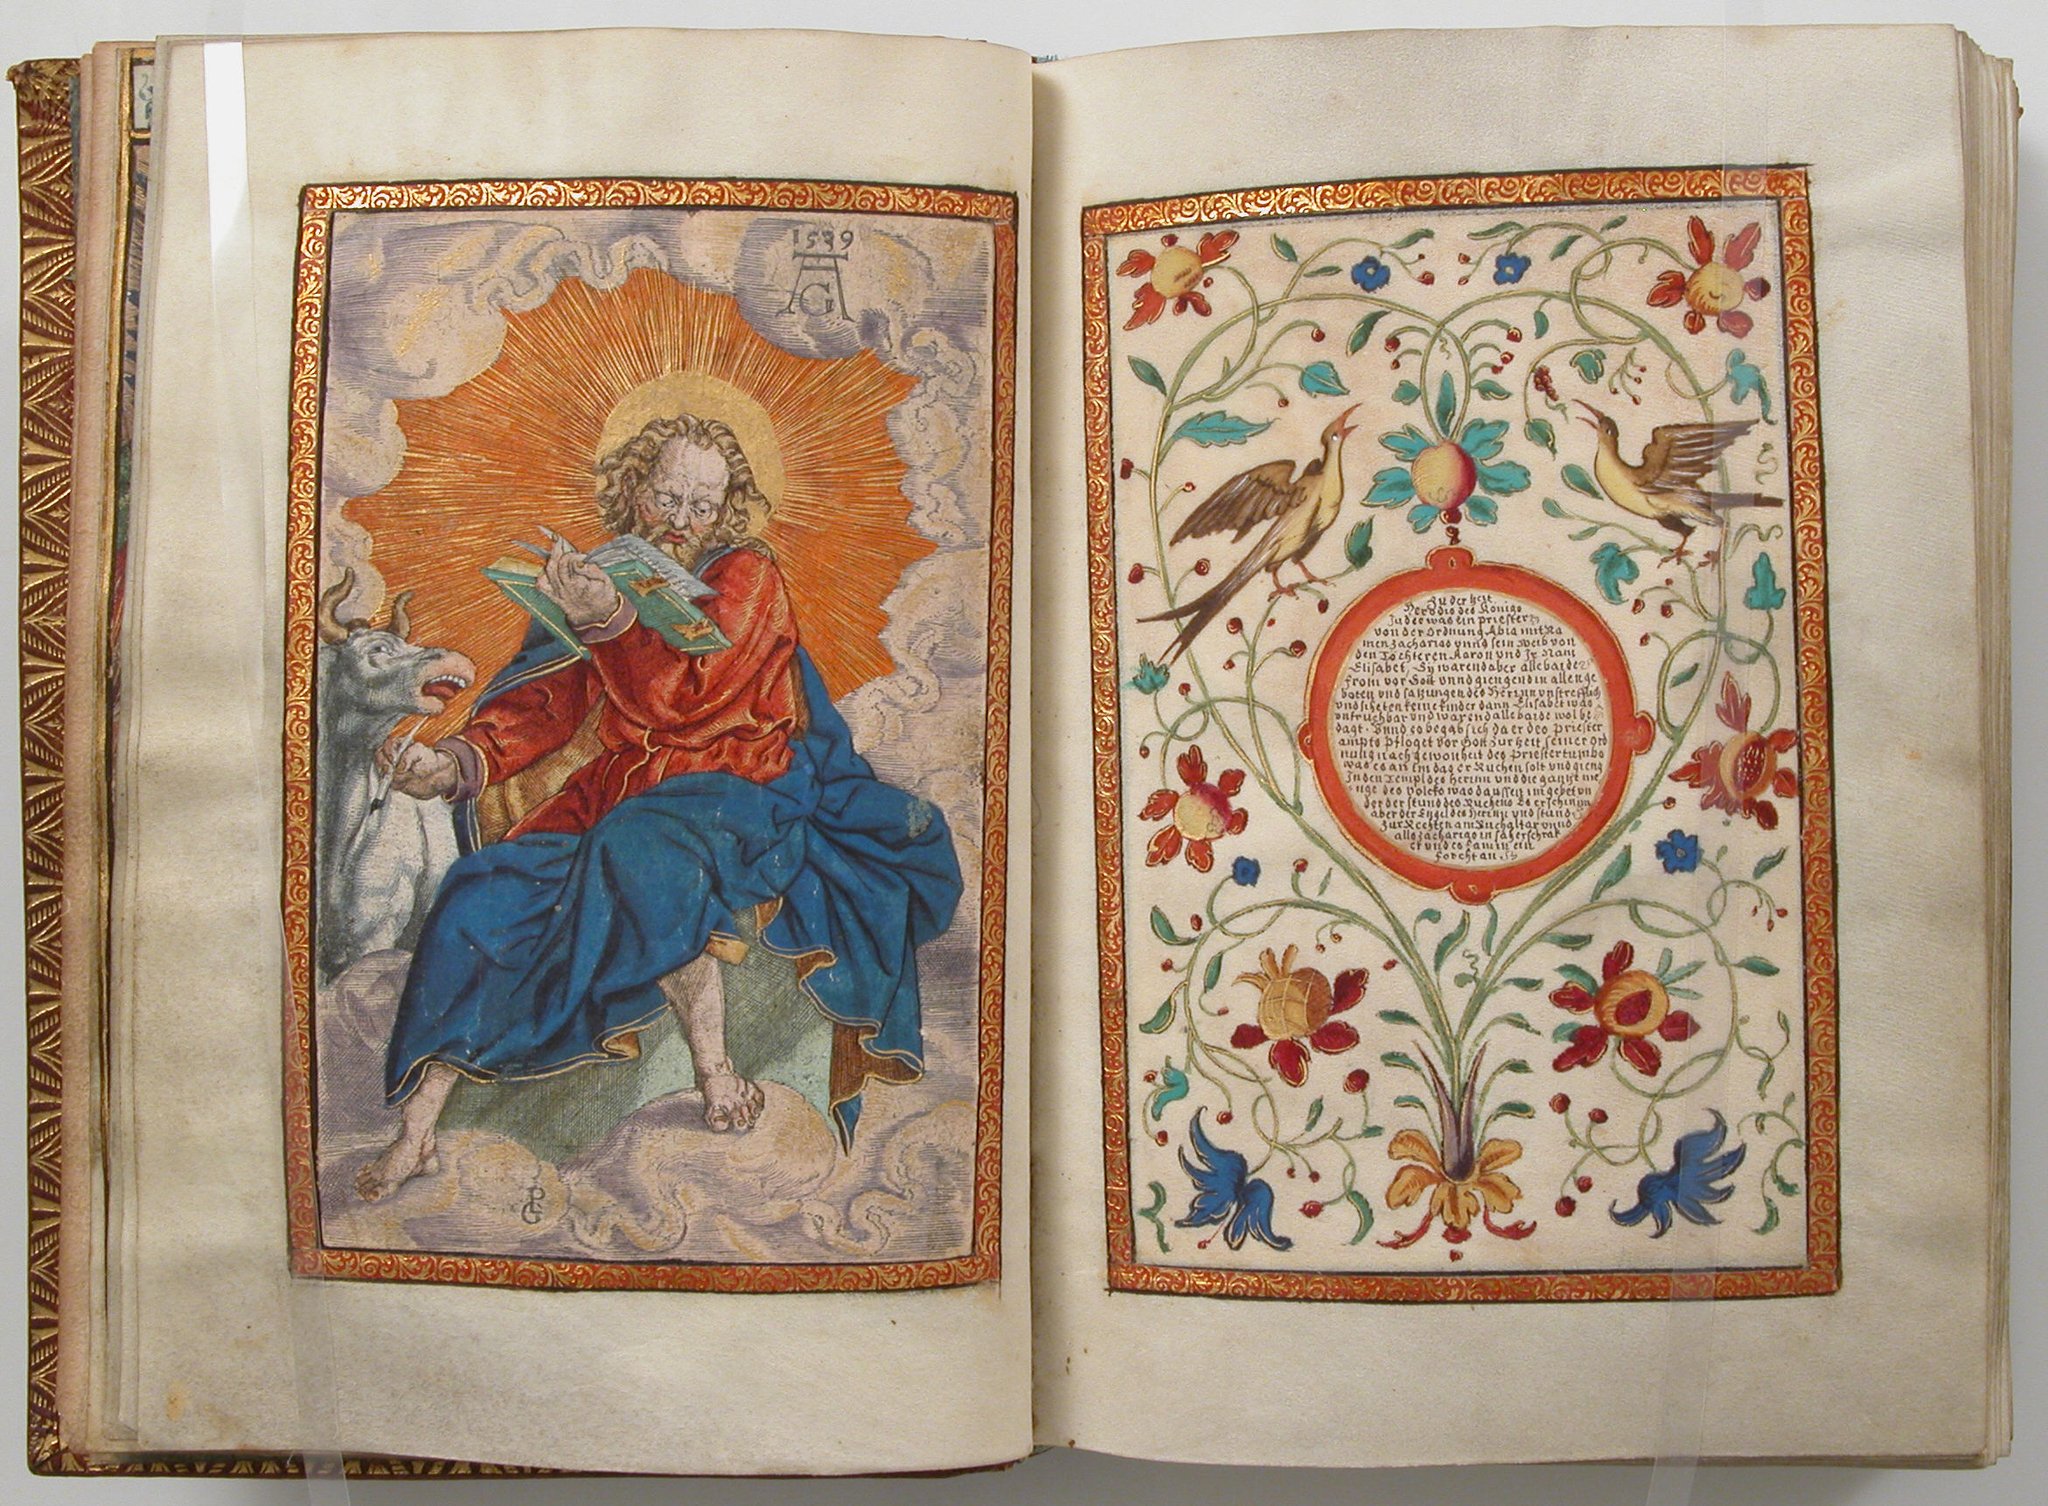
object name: book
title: Das Leben Und Evangelischen Historien Von Jesu Christ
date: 1780-1790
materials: ink, leather, metal leaf, parchment, paint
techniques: bookbinding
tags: birds,men,bulls,flowers